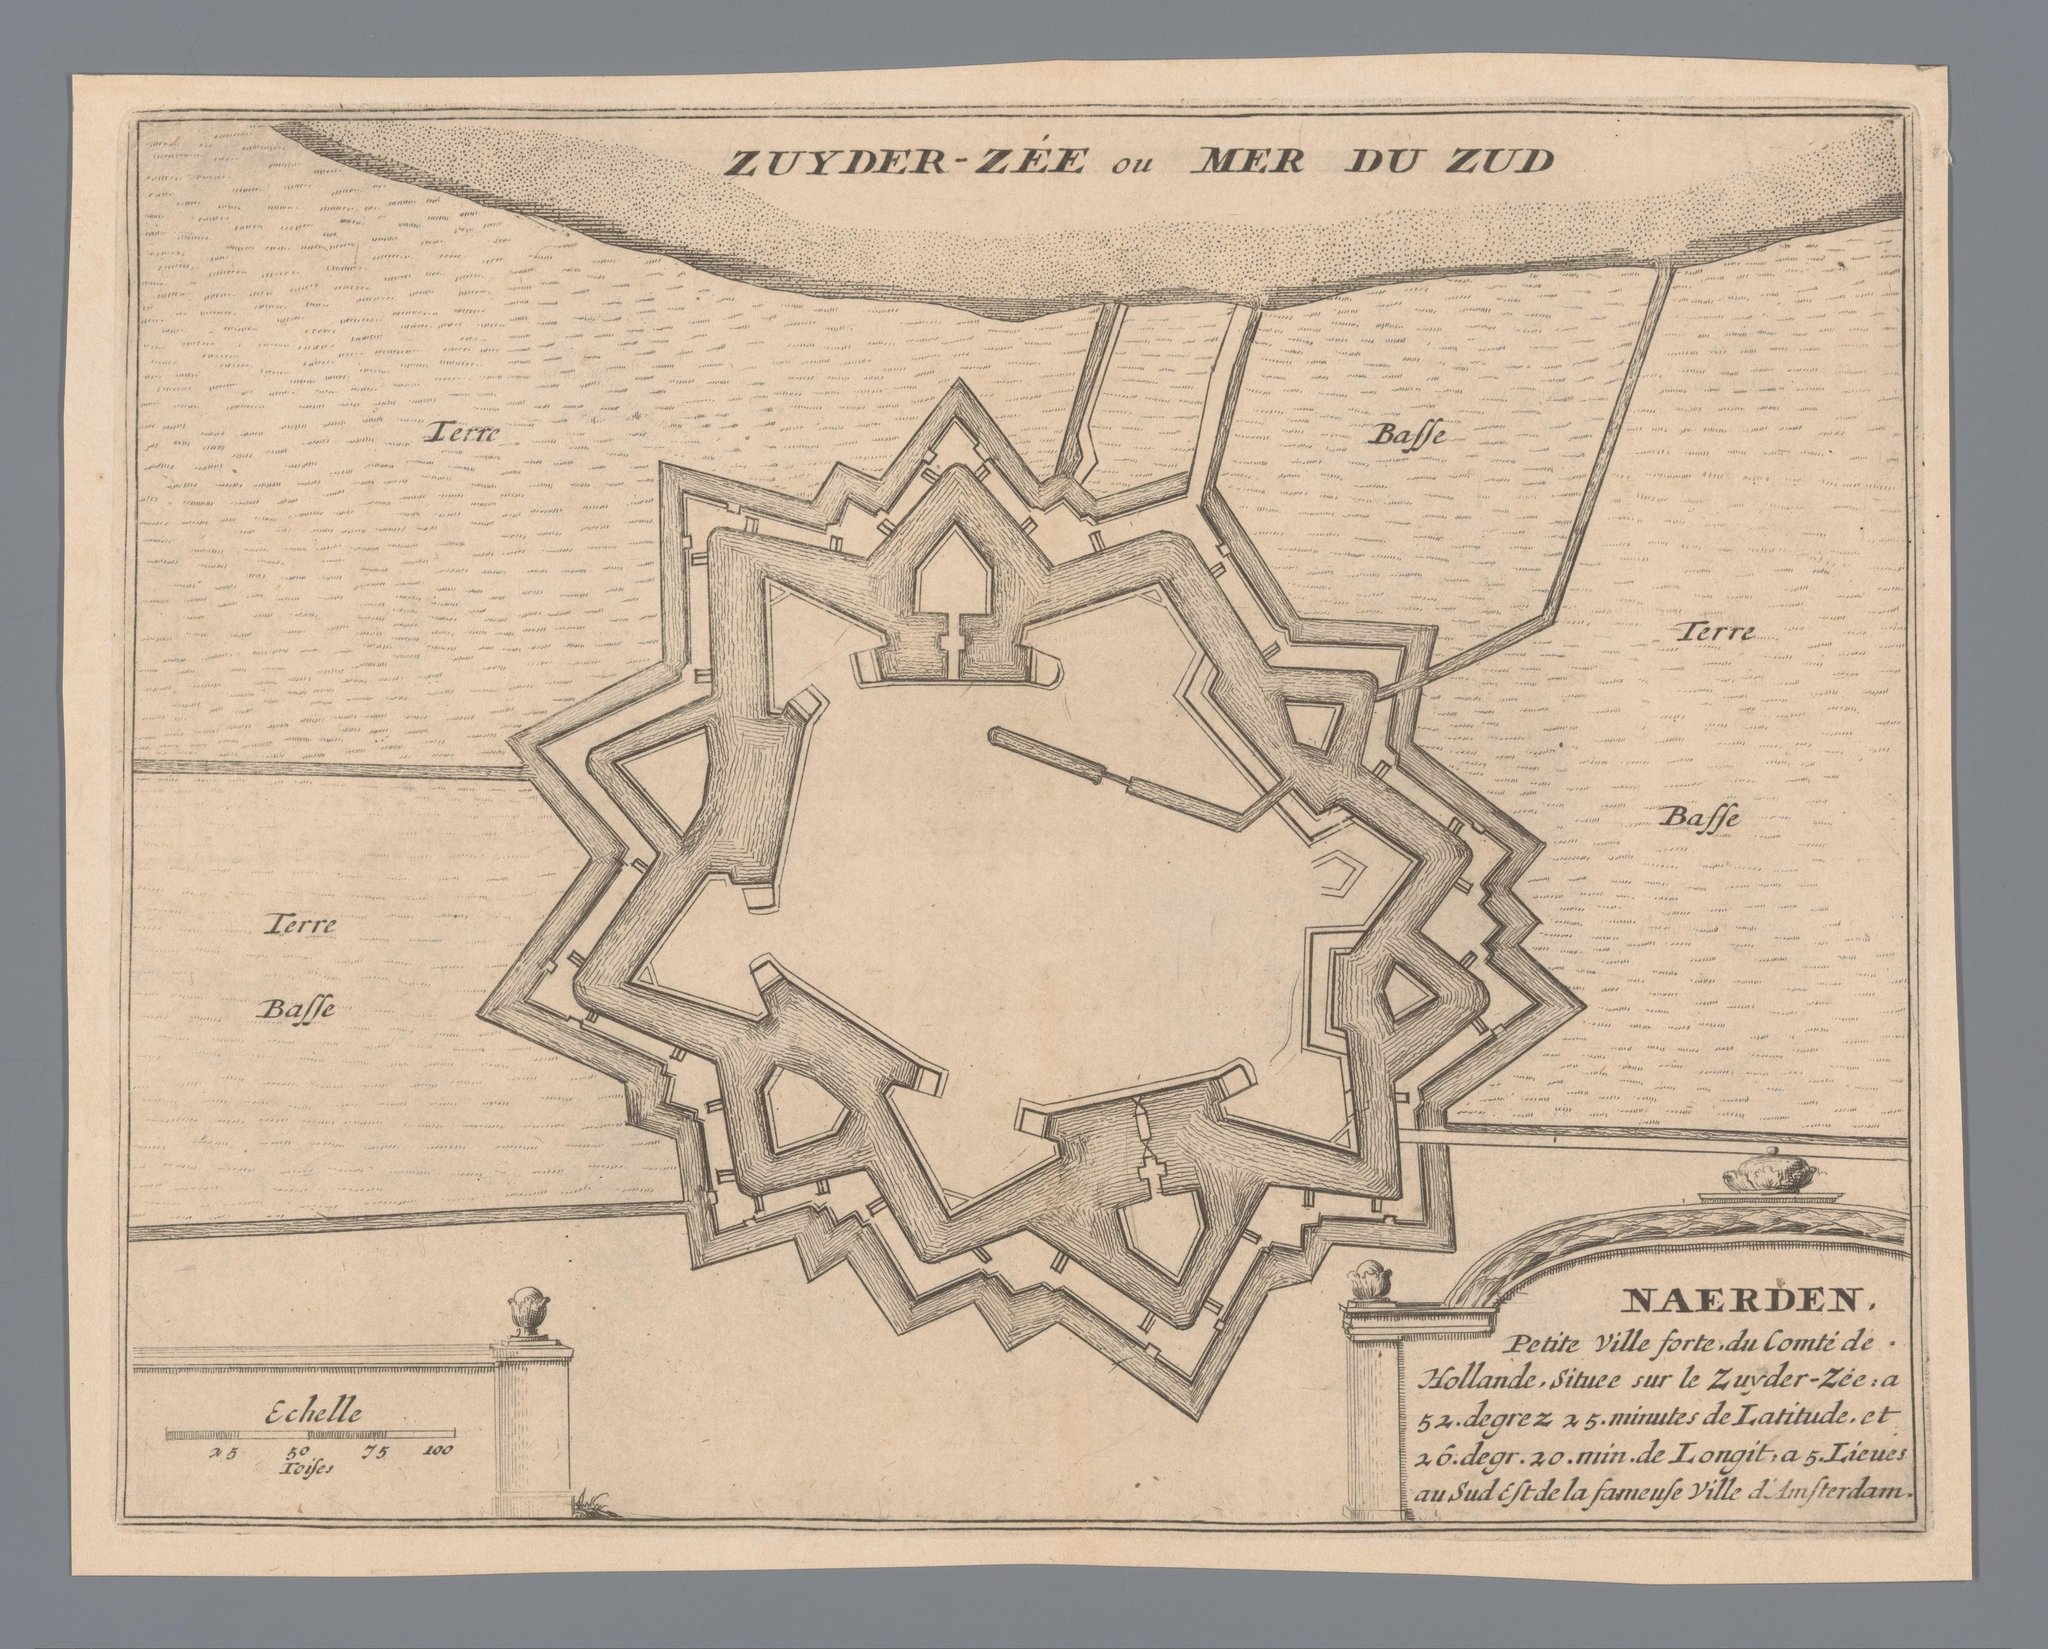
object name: area plan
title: Vestingplattegrond van Naarden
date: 1690-1697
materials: paper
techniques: etching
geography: paris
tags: maps, atlases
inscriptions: watermark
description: Prent voor het eerst gebruikt in: Fer, Nicolas de. Les forces de l'Europe, ou description des principales villes, avec leurs fortifications : dessignées par les meilleurs ingenieurs, particulierement celles (...). Parijs: Nicolas de Fer, 1690-1695. In deze publicatie, evenals in latere publicaties waarin deze prent te vinden is, staan plattegronden van vermaarde sterke steden en vestingen in de Negenjarige Oorlog.